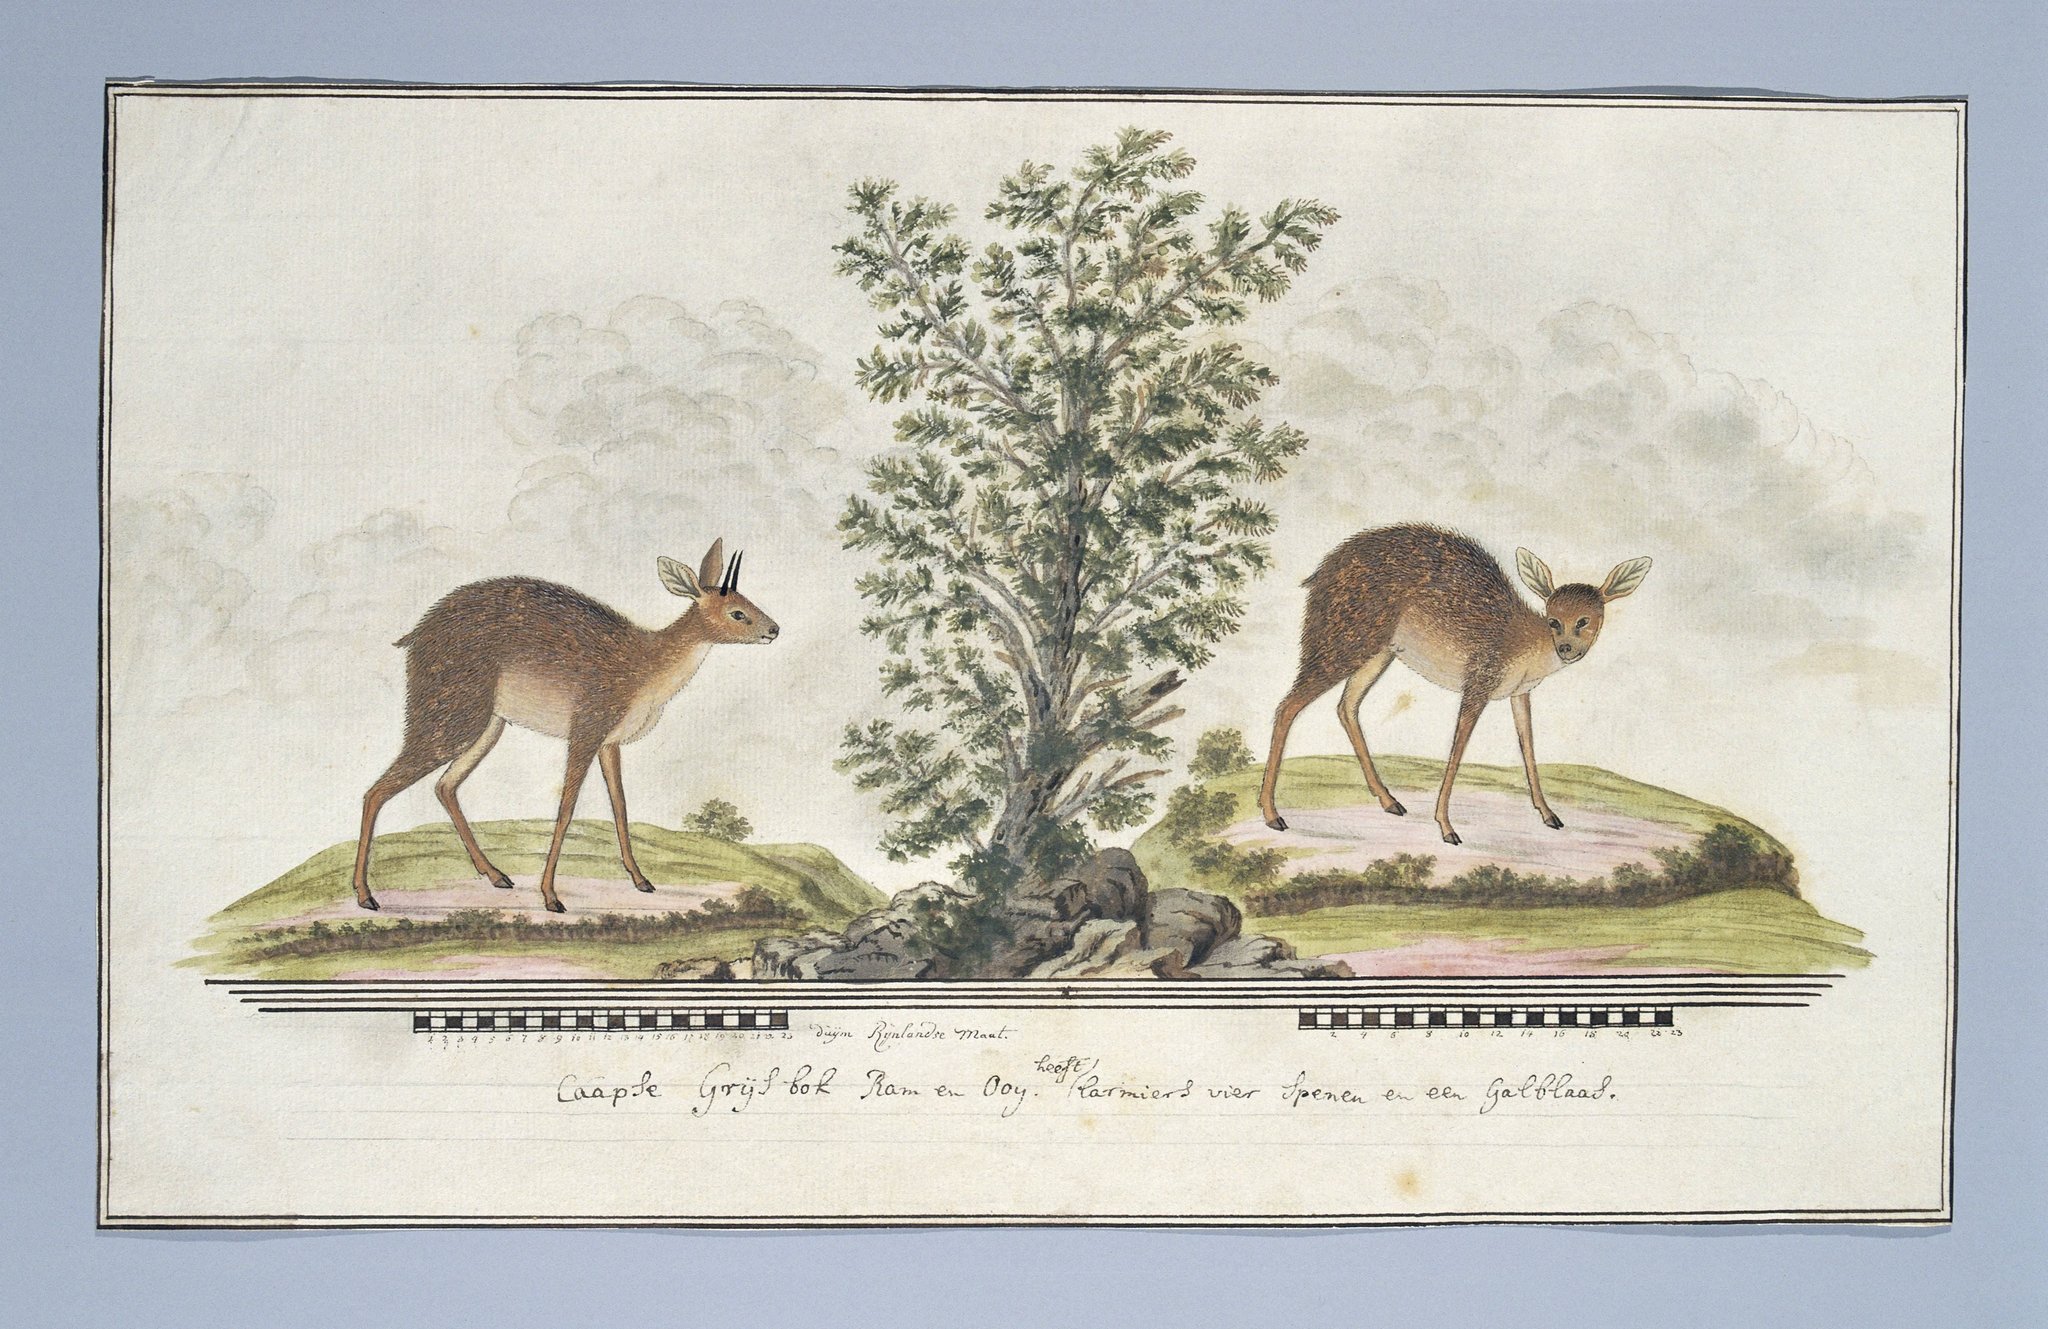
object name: drawing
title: Raphicerus melanotis (Cape grysbok)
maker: robert jacob gordon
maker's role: draughtsman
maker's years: 1743-1795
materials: chalk, ink, paper, pencil, watercolor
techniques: brush, pen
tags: animals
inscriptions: annotation: ‘Caapse Grijsbok Ram en Ooij. [...]; schaalverdelingen met : duijm Rijnlandse Maat. [bij linkerschaal]’